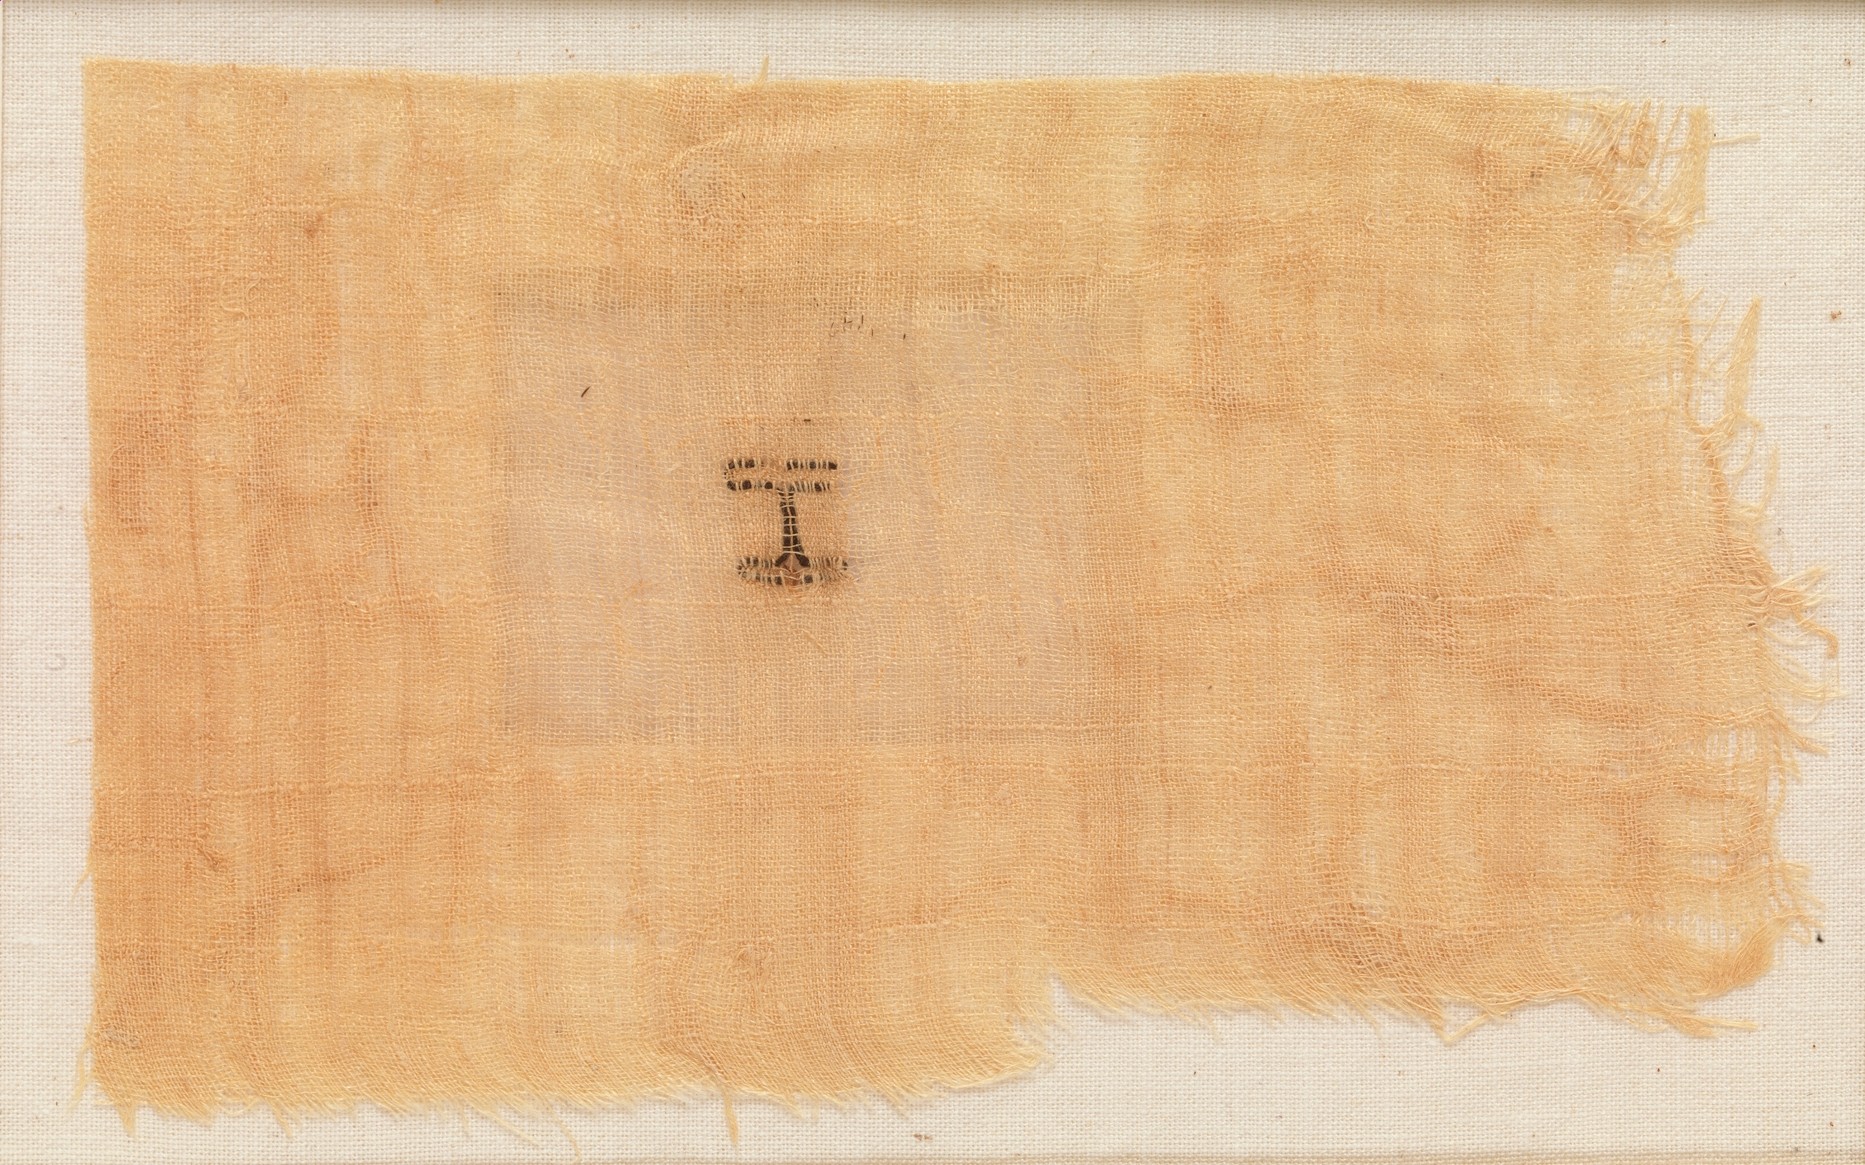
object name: linen mark, wah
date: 1981-1975 BCE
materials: linen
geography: egypt